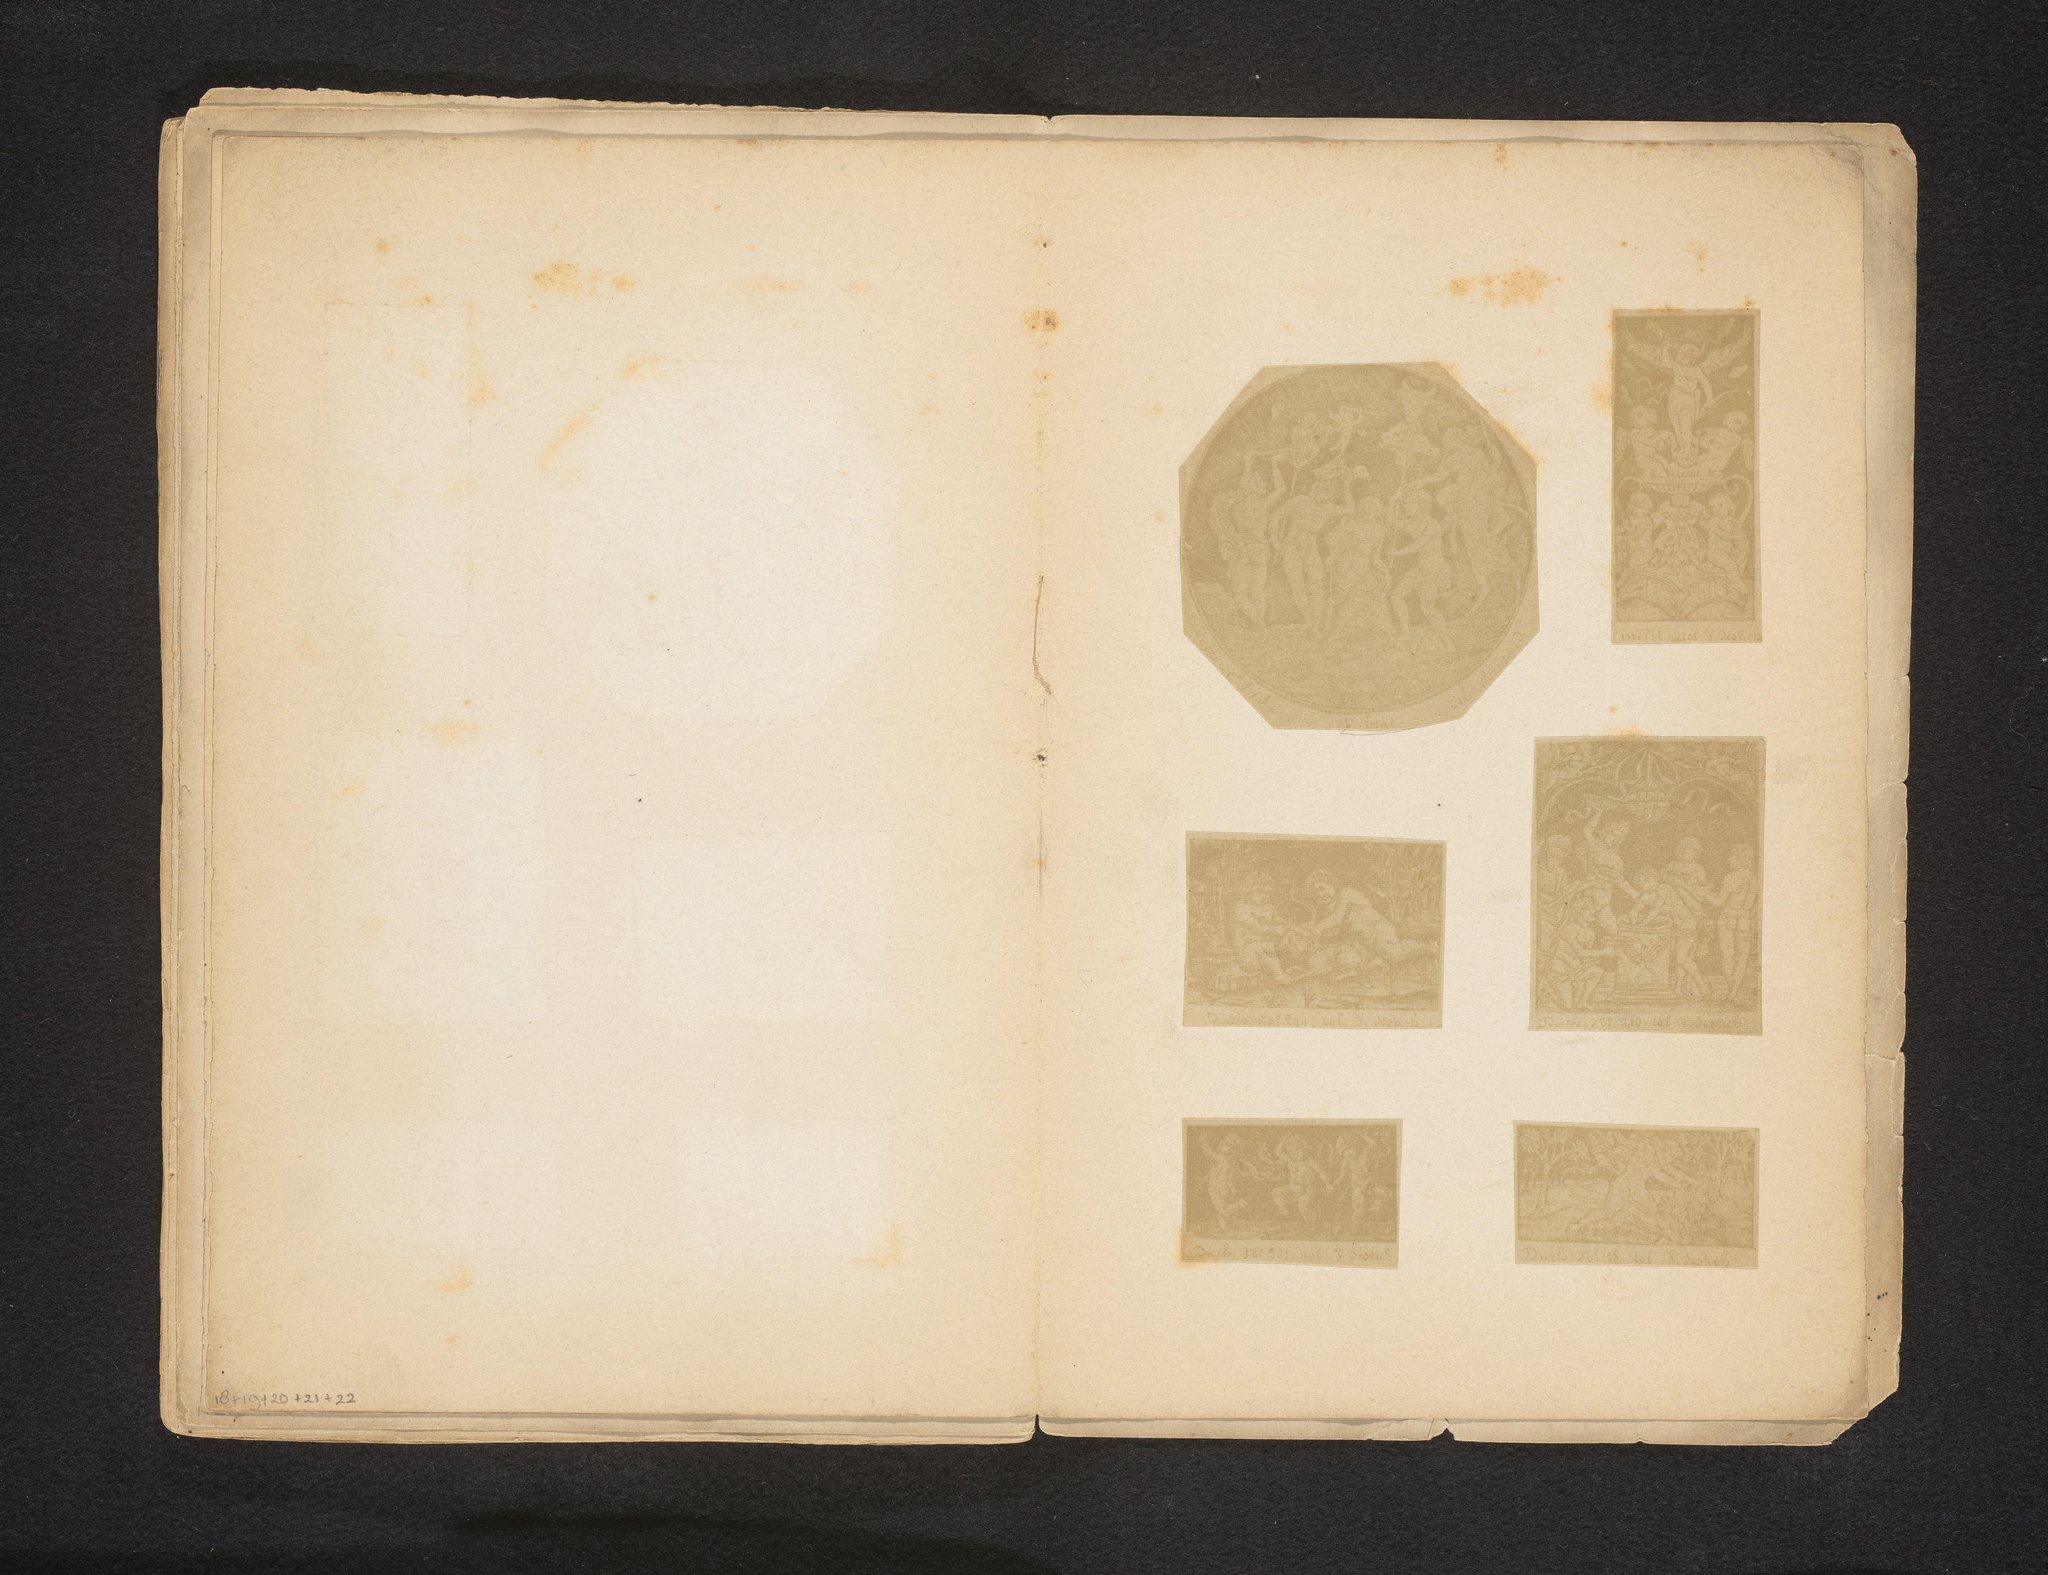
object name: photograph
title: Fotoreproductie van een prent van drie dansende putti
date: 1852-1857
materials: photographic support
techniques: salted paper print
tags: group dancing, cupids: 'amores', 'amoretti', 'putti'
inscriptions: inscription: ‘Duch. No 291. col. V. Sestich’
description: Foto op blad met zes foto's op negende ongenummerde pagina na pagina 60.